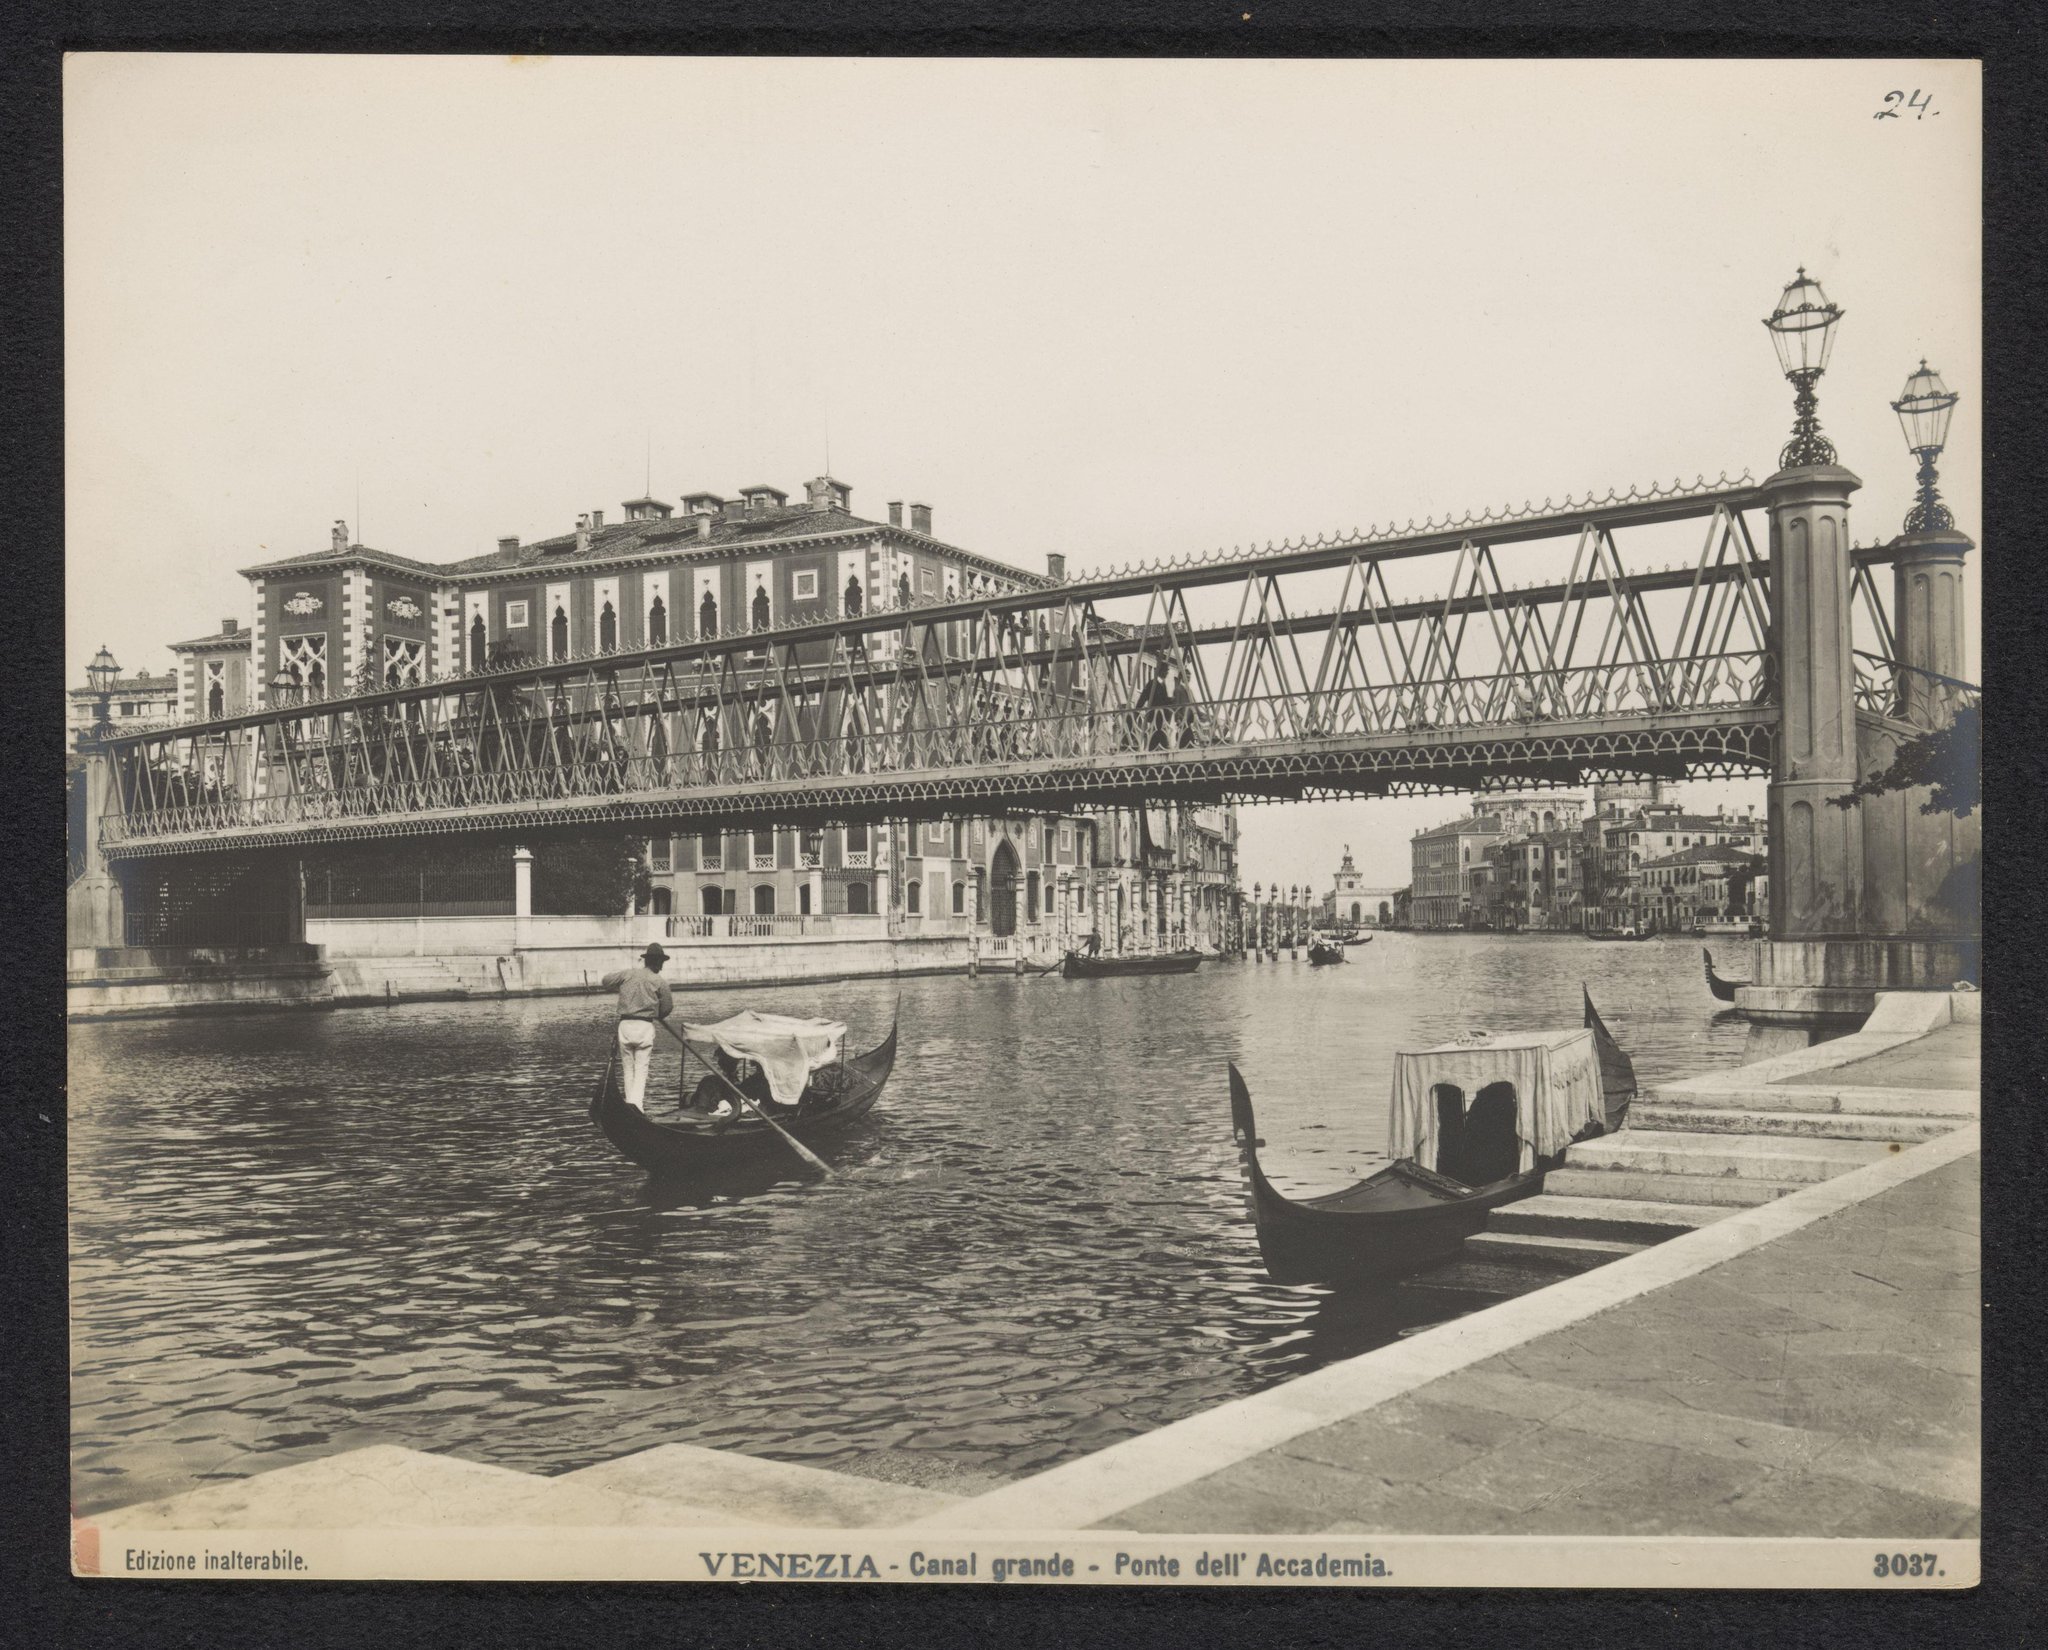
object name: photograph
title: Ponte dell'Accademia te Venetië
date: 1900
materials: cardboard, photographic support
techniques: gelatin silver print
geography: venice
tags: canal, bridge, gondola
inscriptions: number: ‘3037.’, number: ‘24.’